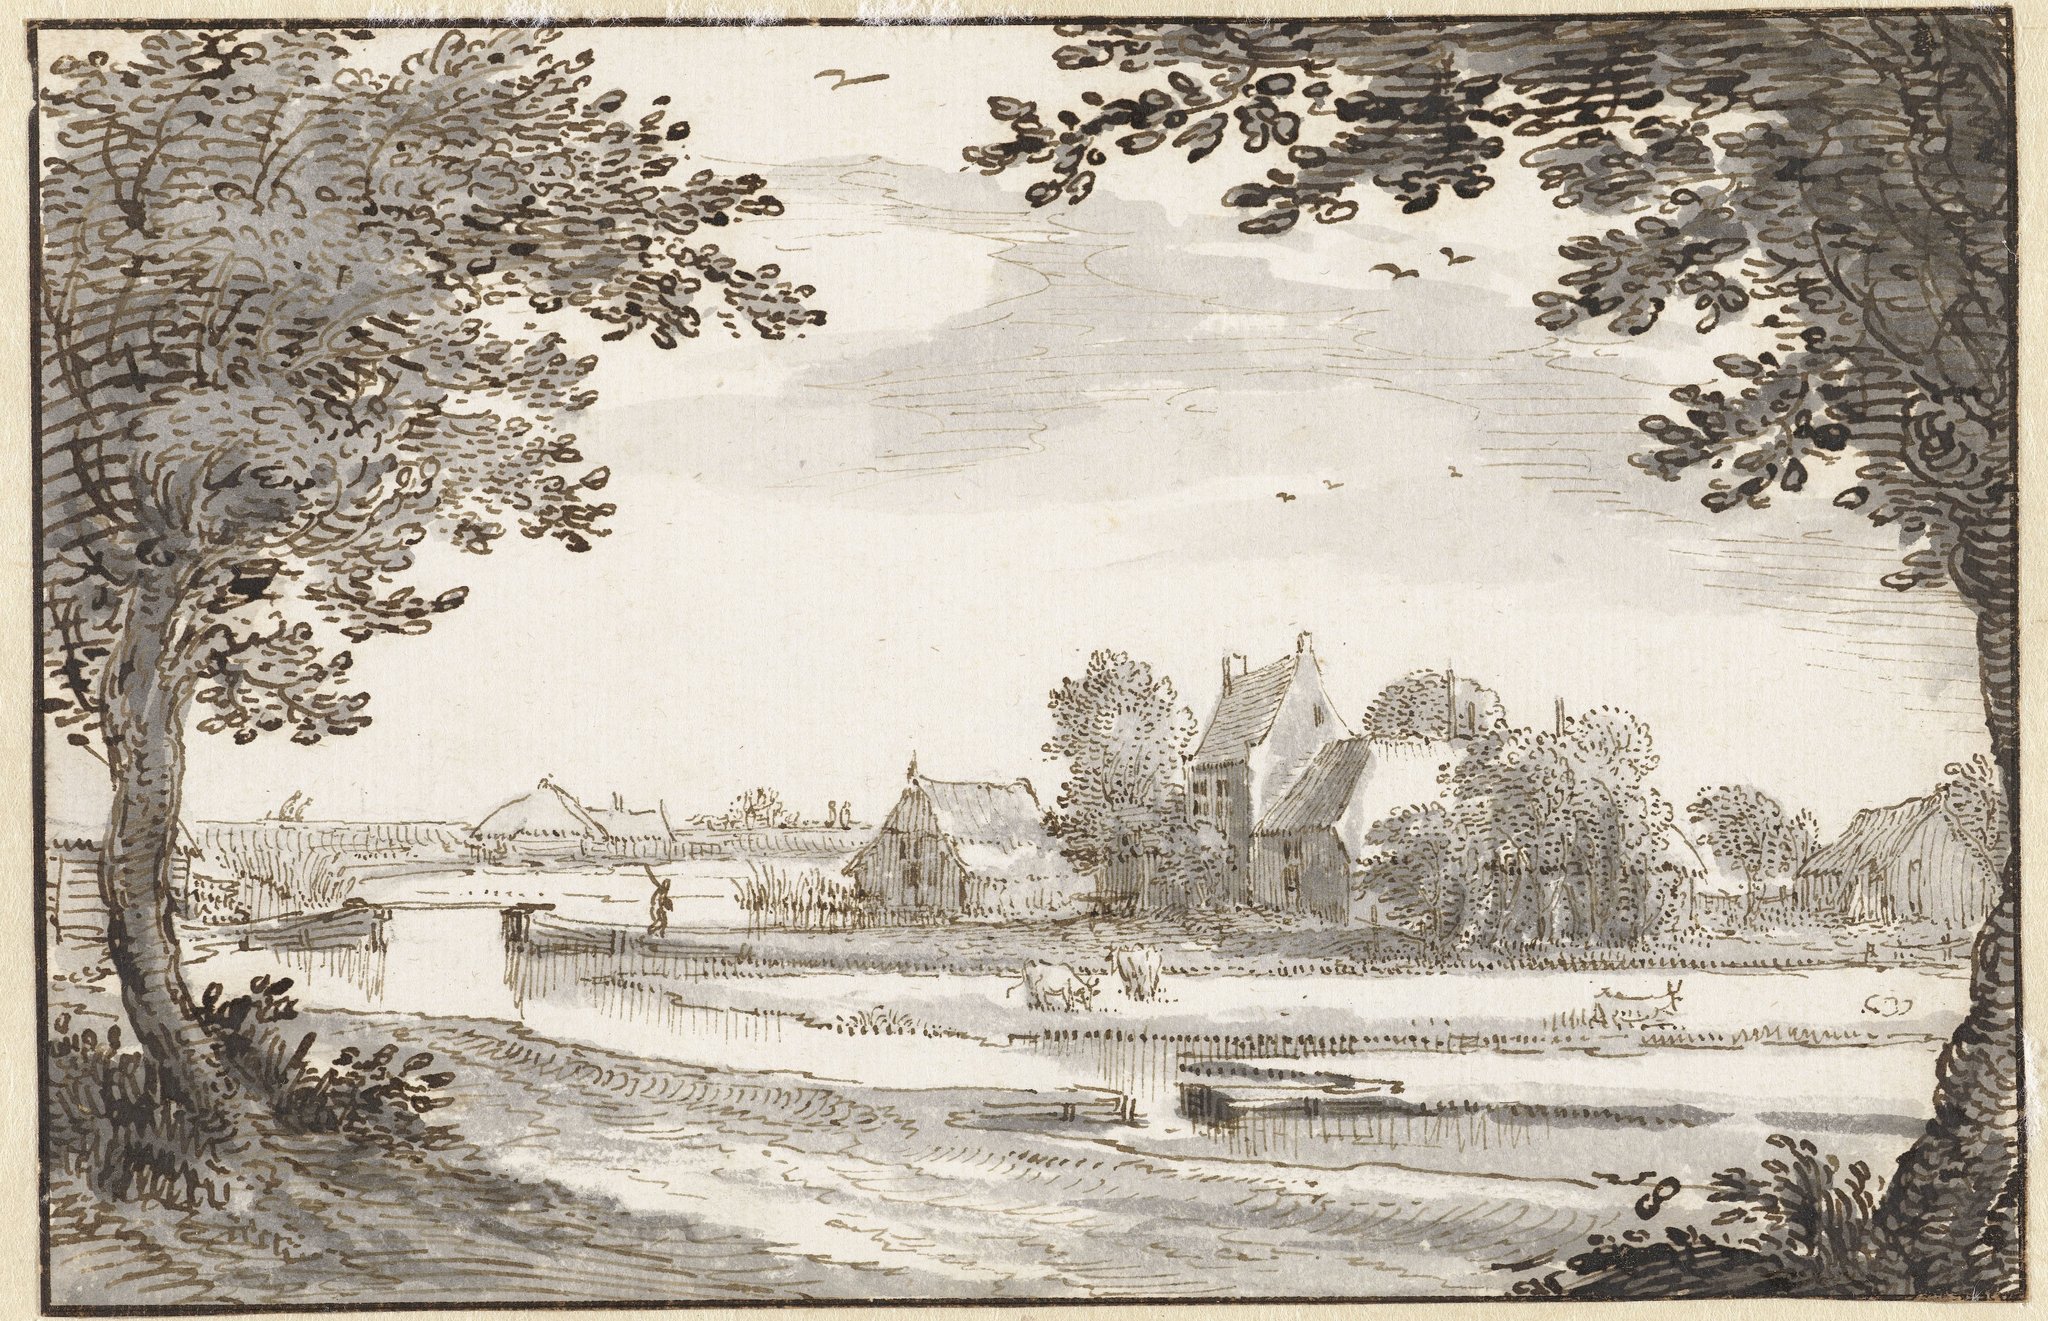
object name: drawing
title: Genummerde dorps- en poldergezichten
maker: claes jansz. visscher (ii)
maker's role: draughtsman, print maker, publisher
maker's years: 1586-1652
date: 1596-1652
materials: ink, paper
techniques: brush, pen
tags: farm or solitary house in landscape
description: incompleet, drie van de zeven bekende tekeningen in RPK